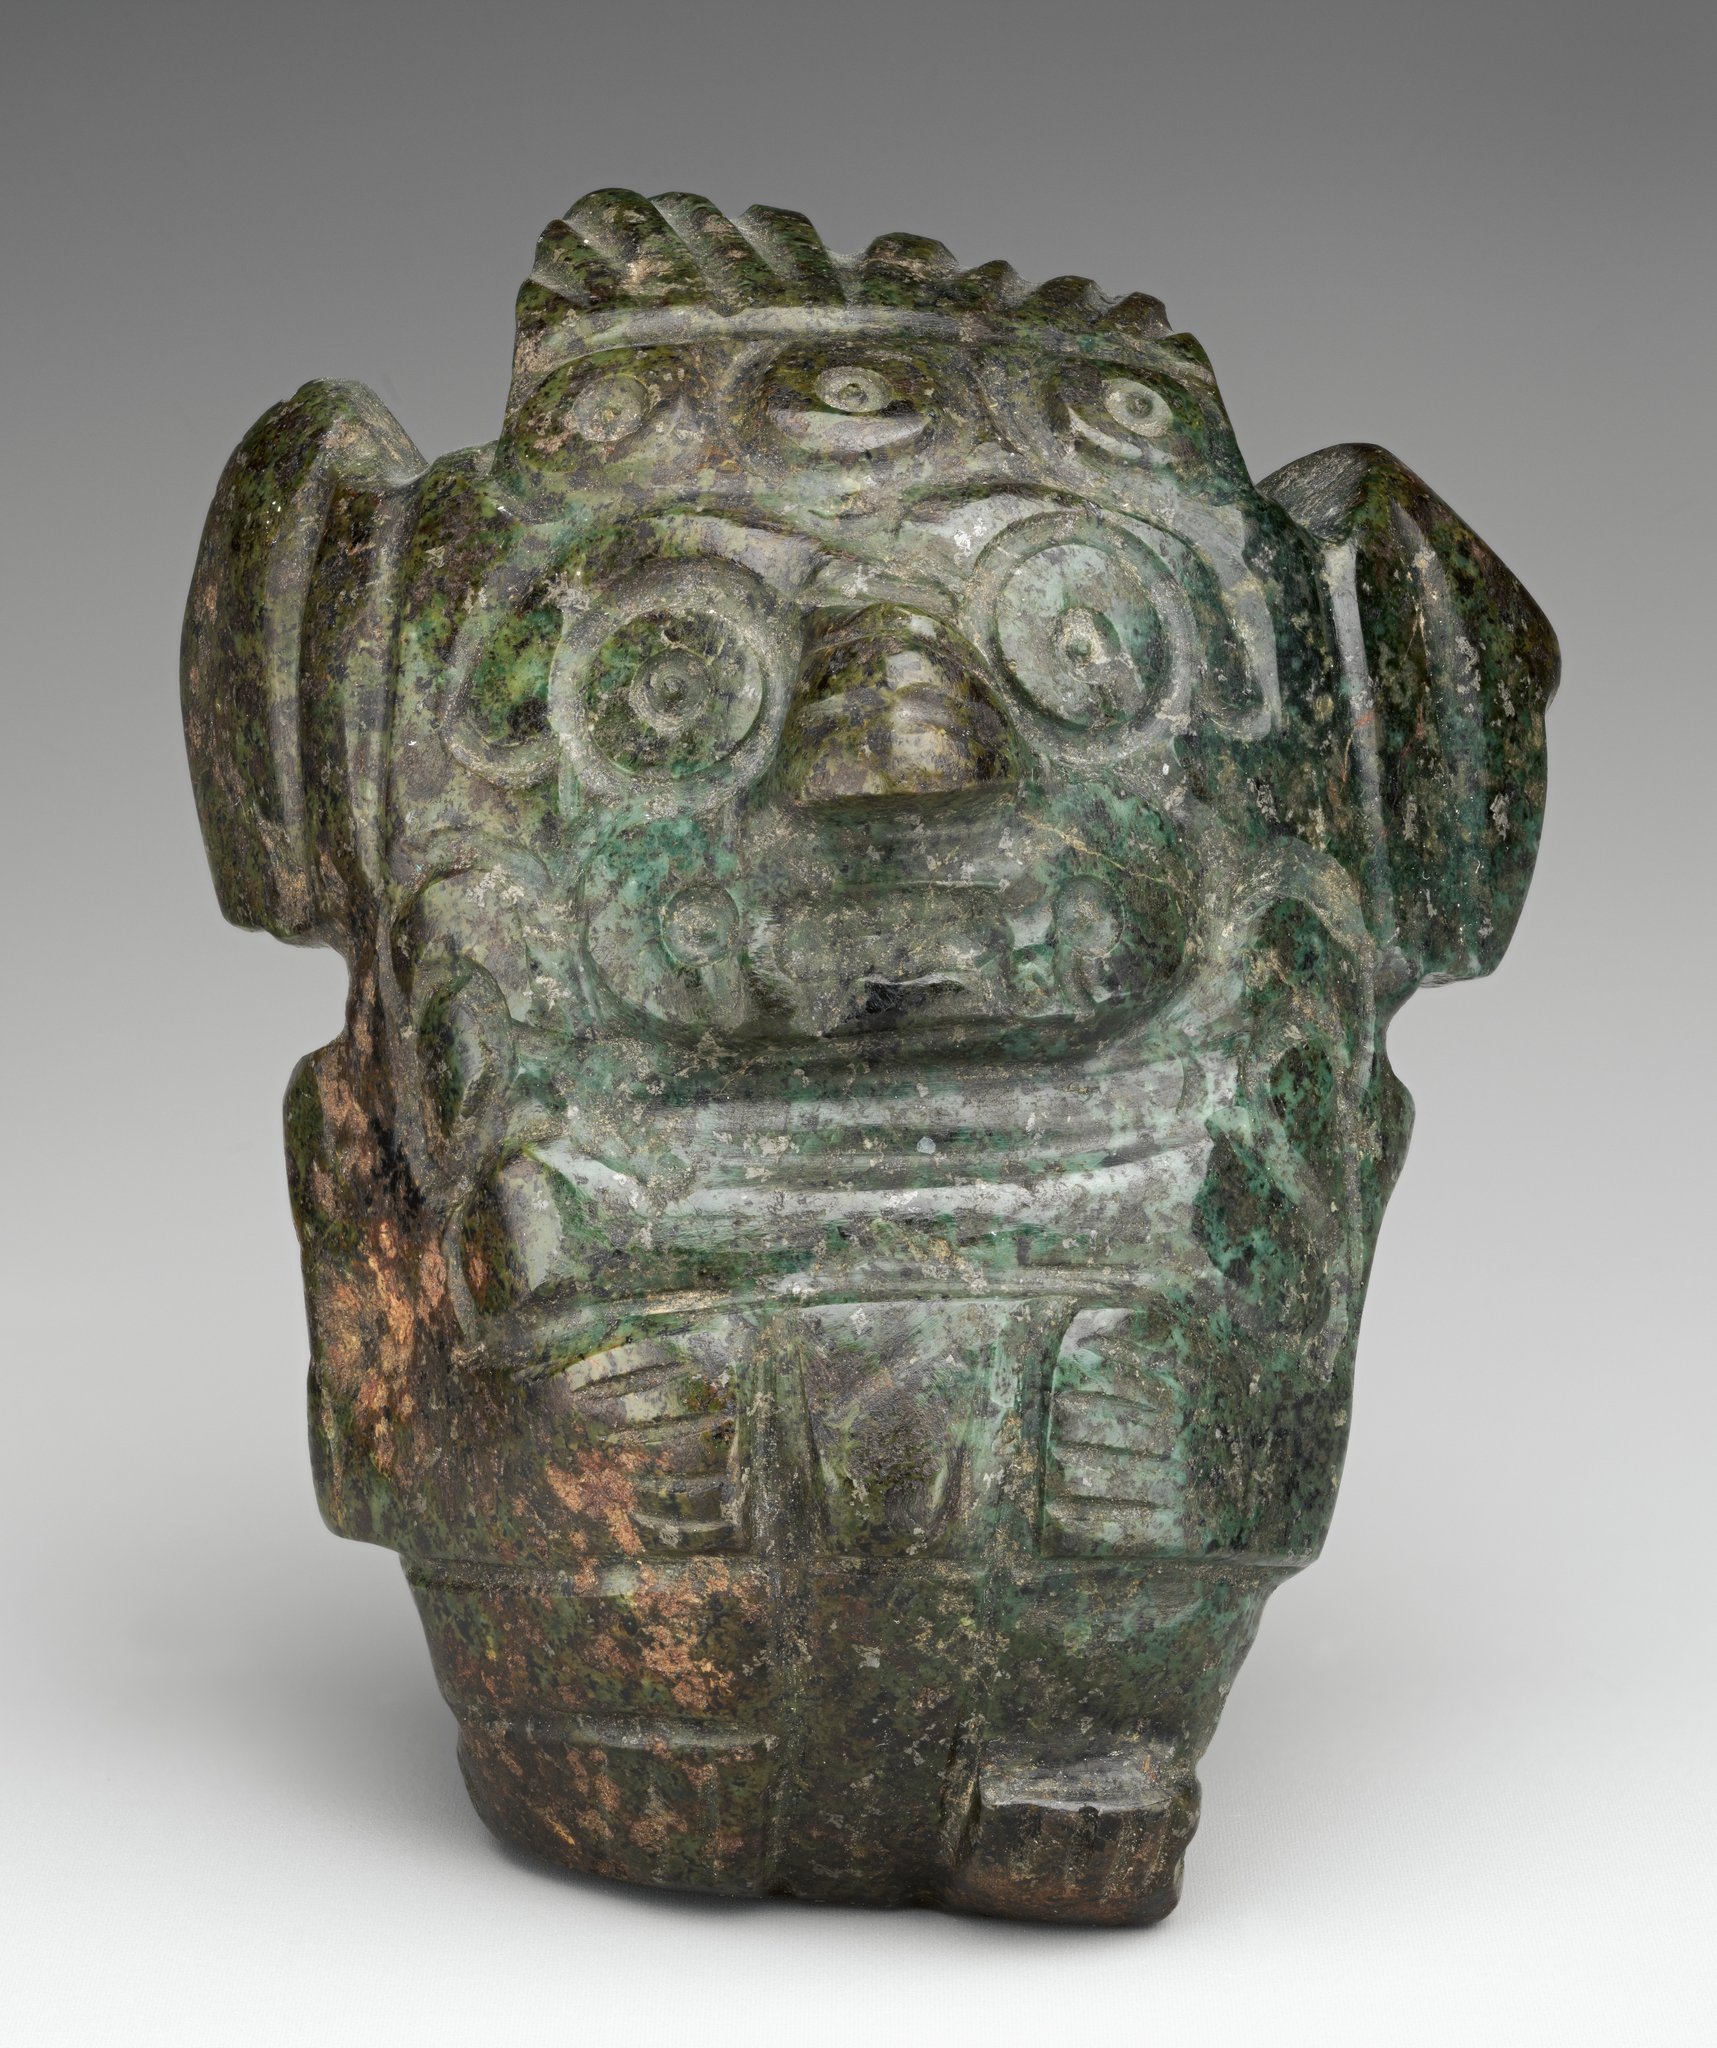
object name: pendant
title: Rain god pendant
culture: mixtec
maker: mexica artist(s)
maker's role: artist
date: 1325-1521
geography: mexico